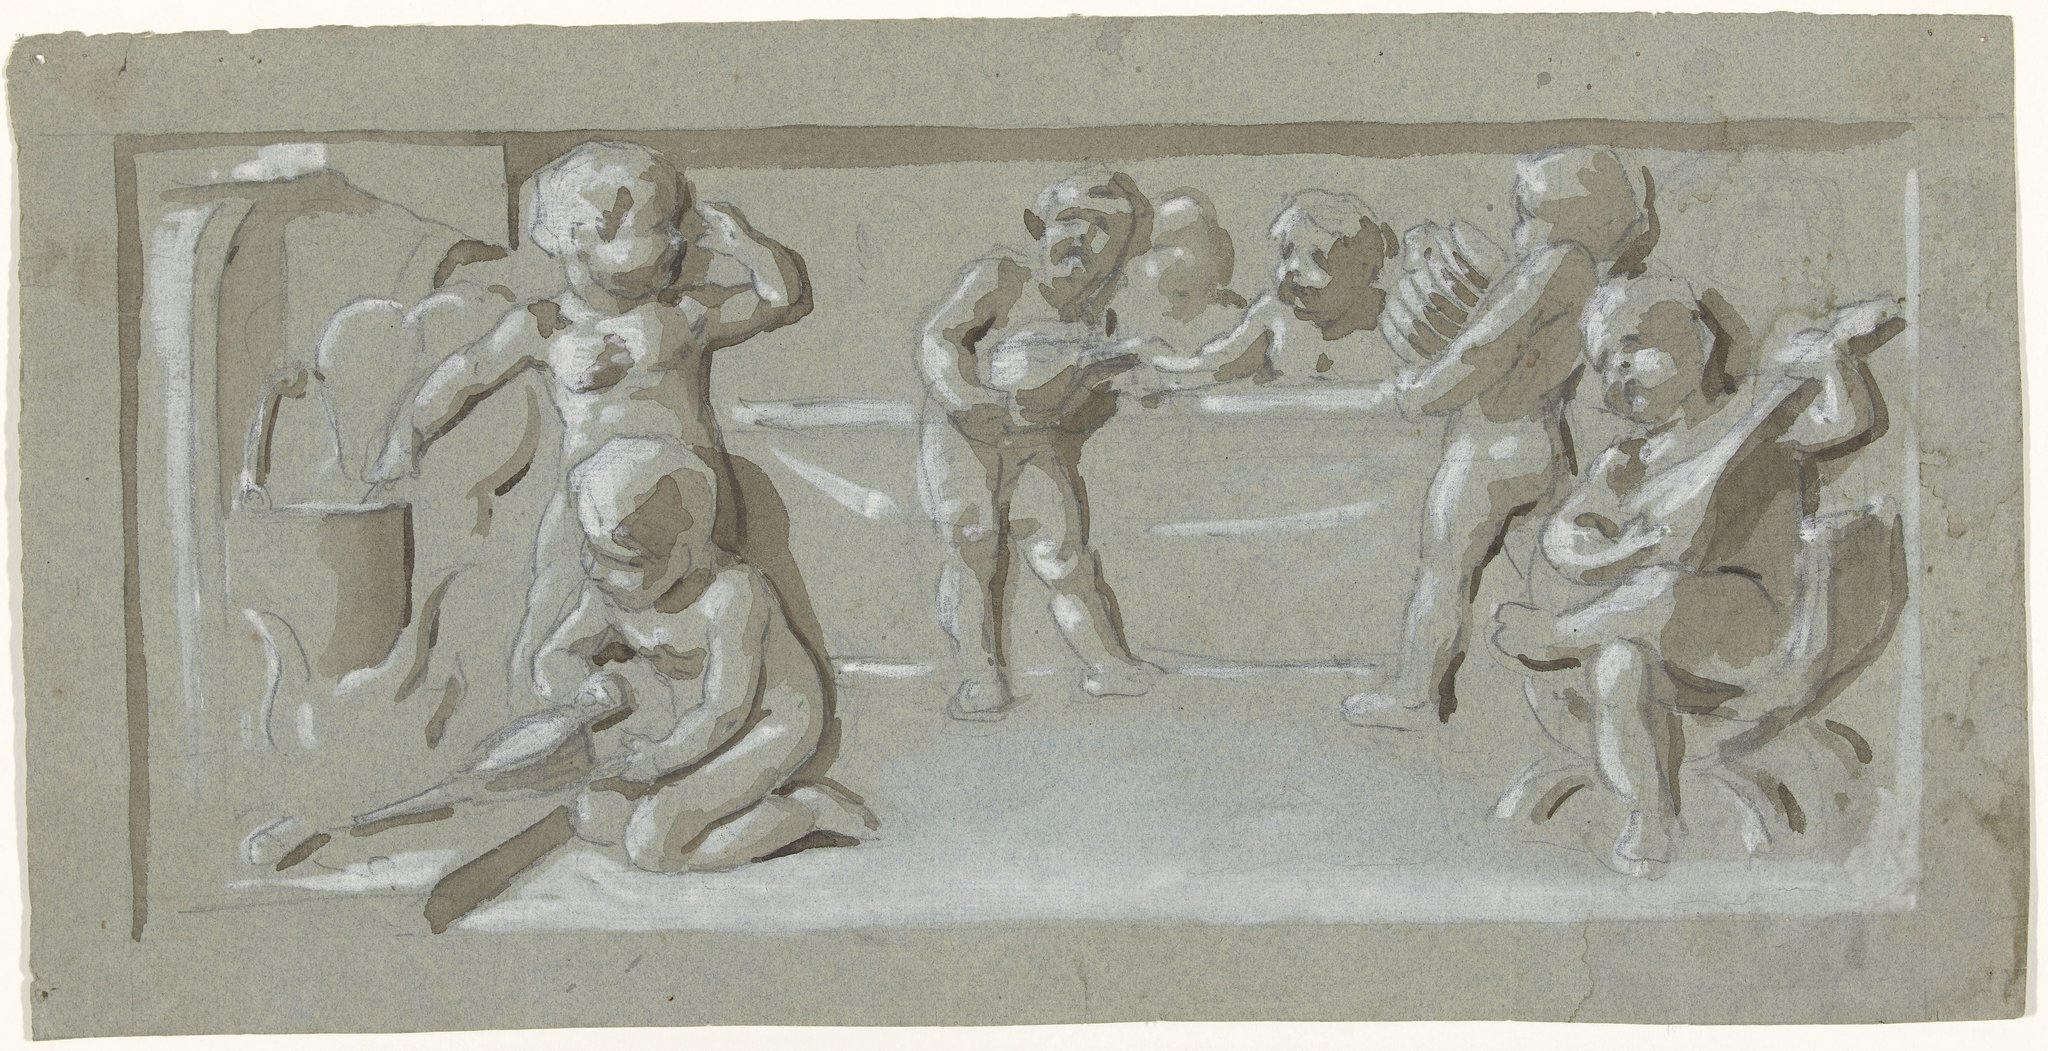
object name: drawing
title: Fries met kokende, etende en musicerende putti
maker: johan braakensiek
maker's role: draughtsman, print maker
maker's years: 1858-1940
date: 1868-1940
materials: paint, paper, pencil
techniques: brush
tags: muscles